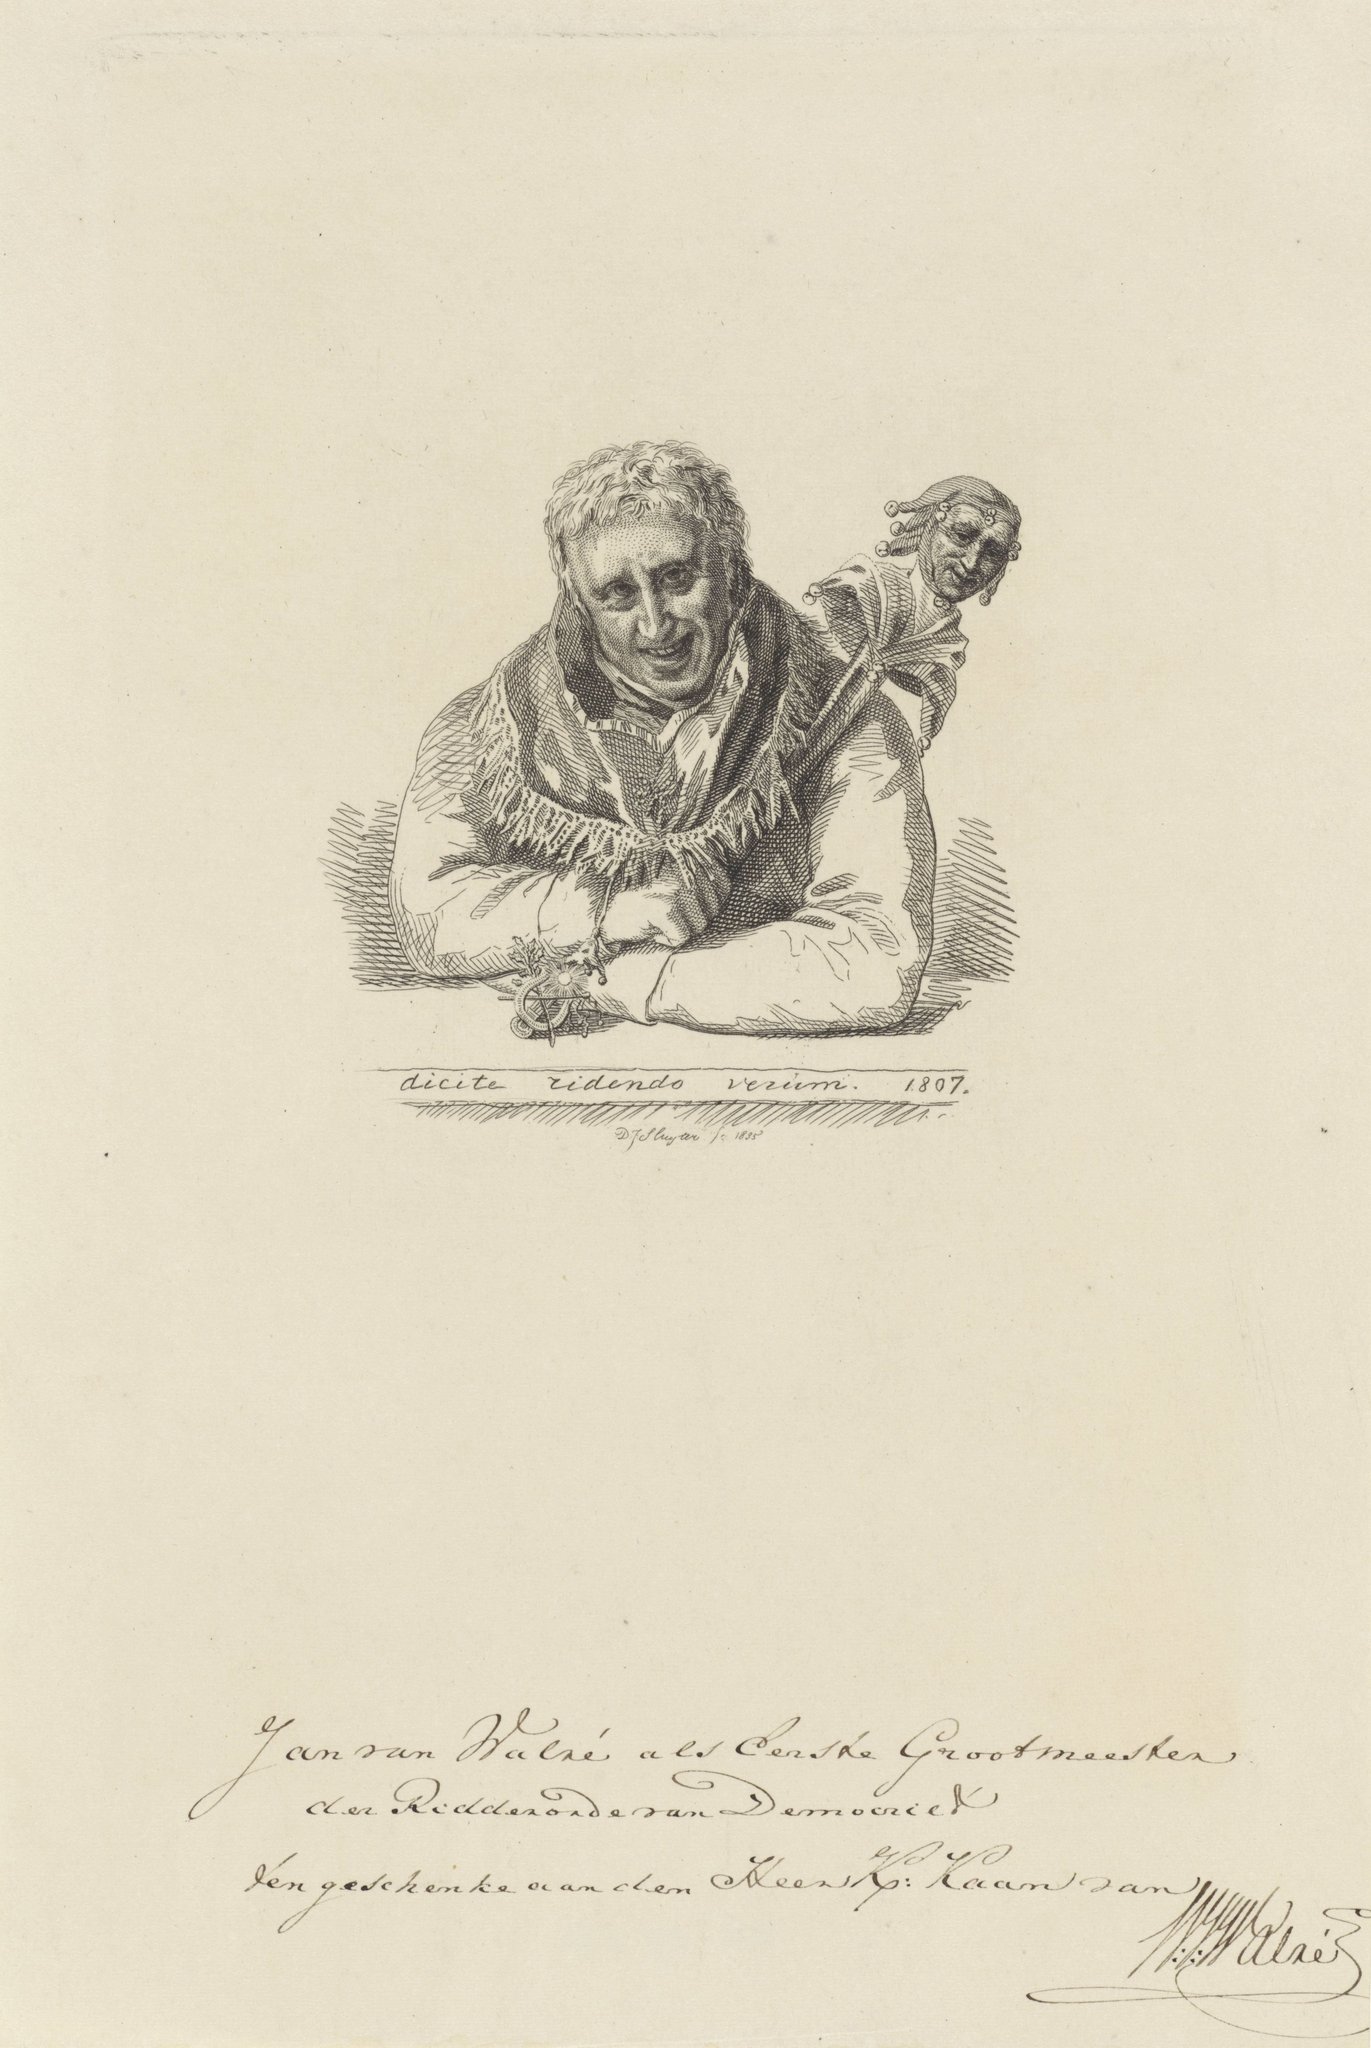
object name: print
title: Portret van Jan van Walré met een narrenstaf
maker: dirk jurriaan sluyter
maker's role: draughtsman, print maker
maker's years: 1811-1886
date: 1835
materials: paper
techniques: engraving, etching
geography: amsterdam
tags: haarlem, publisher, jan van walré, fool's cap, attributes of court jester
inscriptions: collector's mark: Lugt 2228, inscription: ‘Jan van Walré als Eerste Grootmeester der Ridderorde van Democriet ten geschenke aan den Heer K: Kaan van [H.J.?] Walré’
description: Portret van Jan van Walré met een narrenstaf en een zotskap, gemaakt ter herinnering aan zijn grootmeesterschap van het satyrisch dichtgenootschap Democriet uit Haarlem in 1807. Onder het portet de zinsspreuk 'Dicite ridendo verum'.